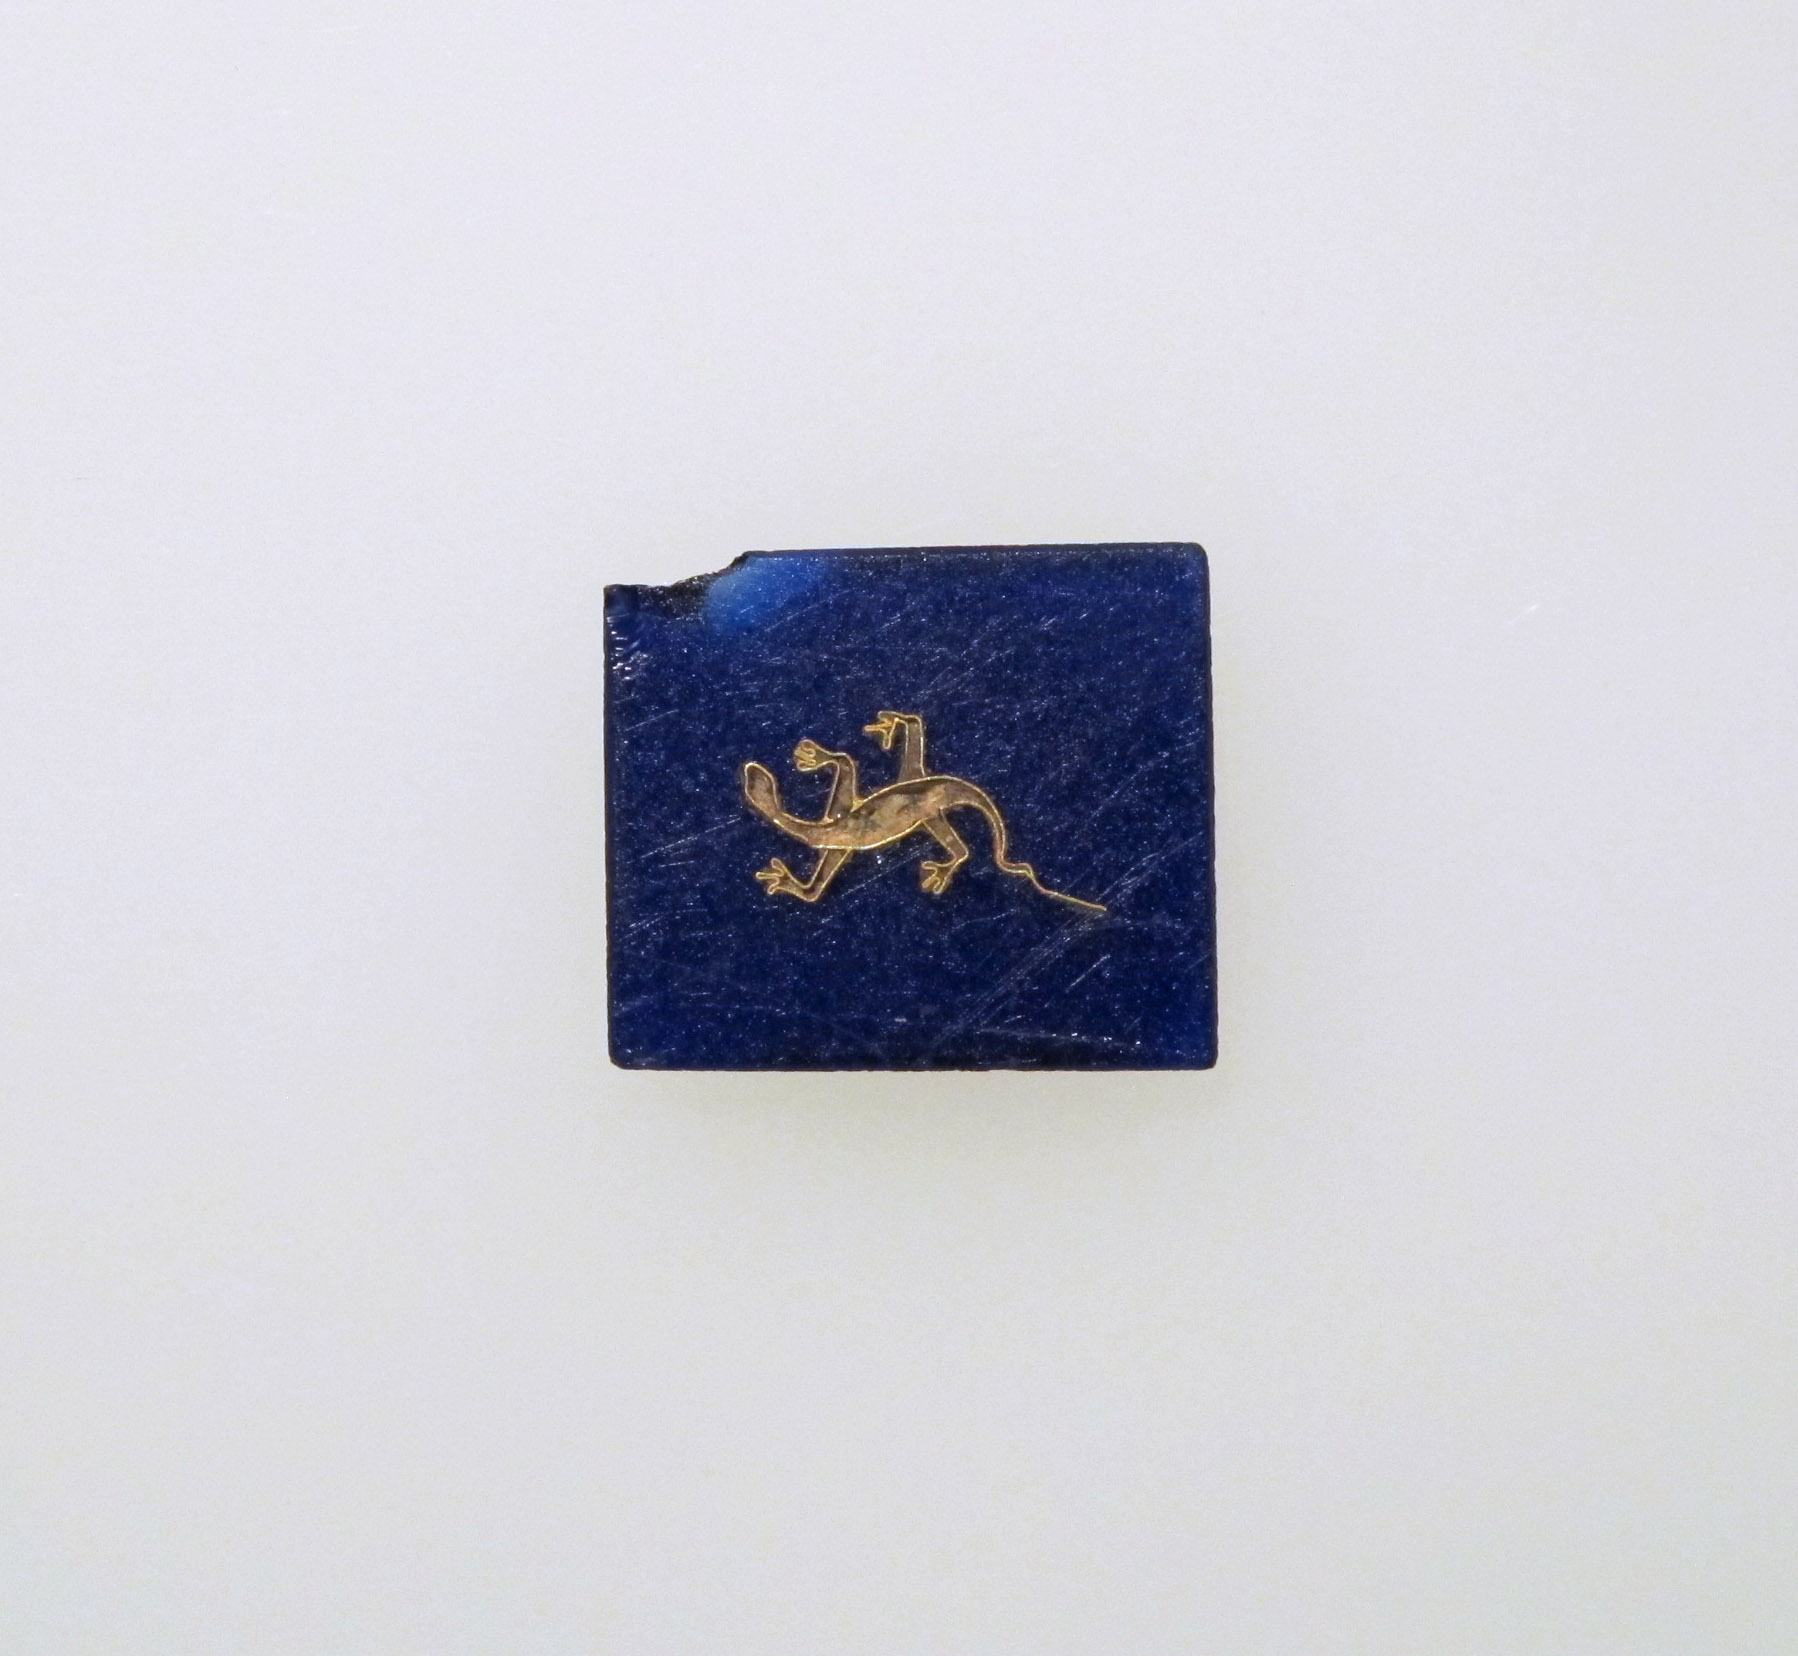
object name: mosaic block inlay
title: Glass and gold inlay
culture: roman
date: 34 BCE-100 CE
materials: glass, gold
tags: lizards